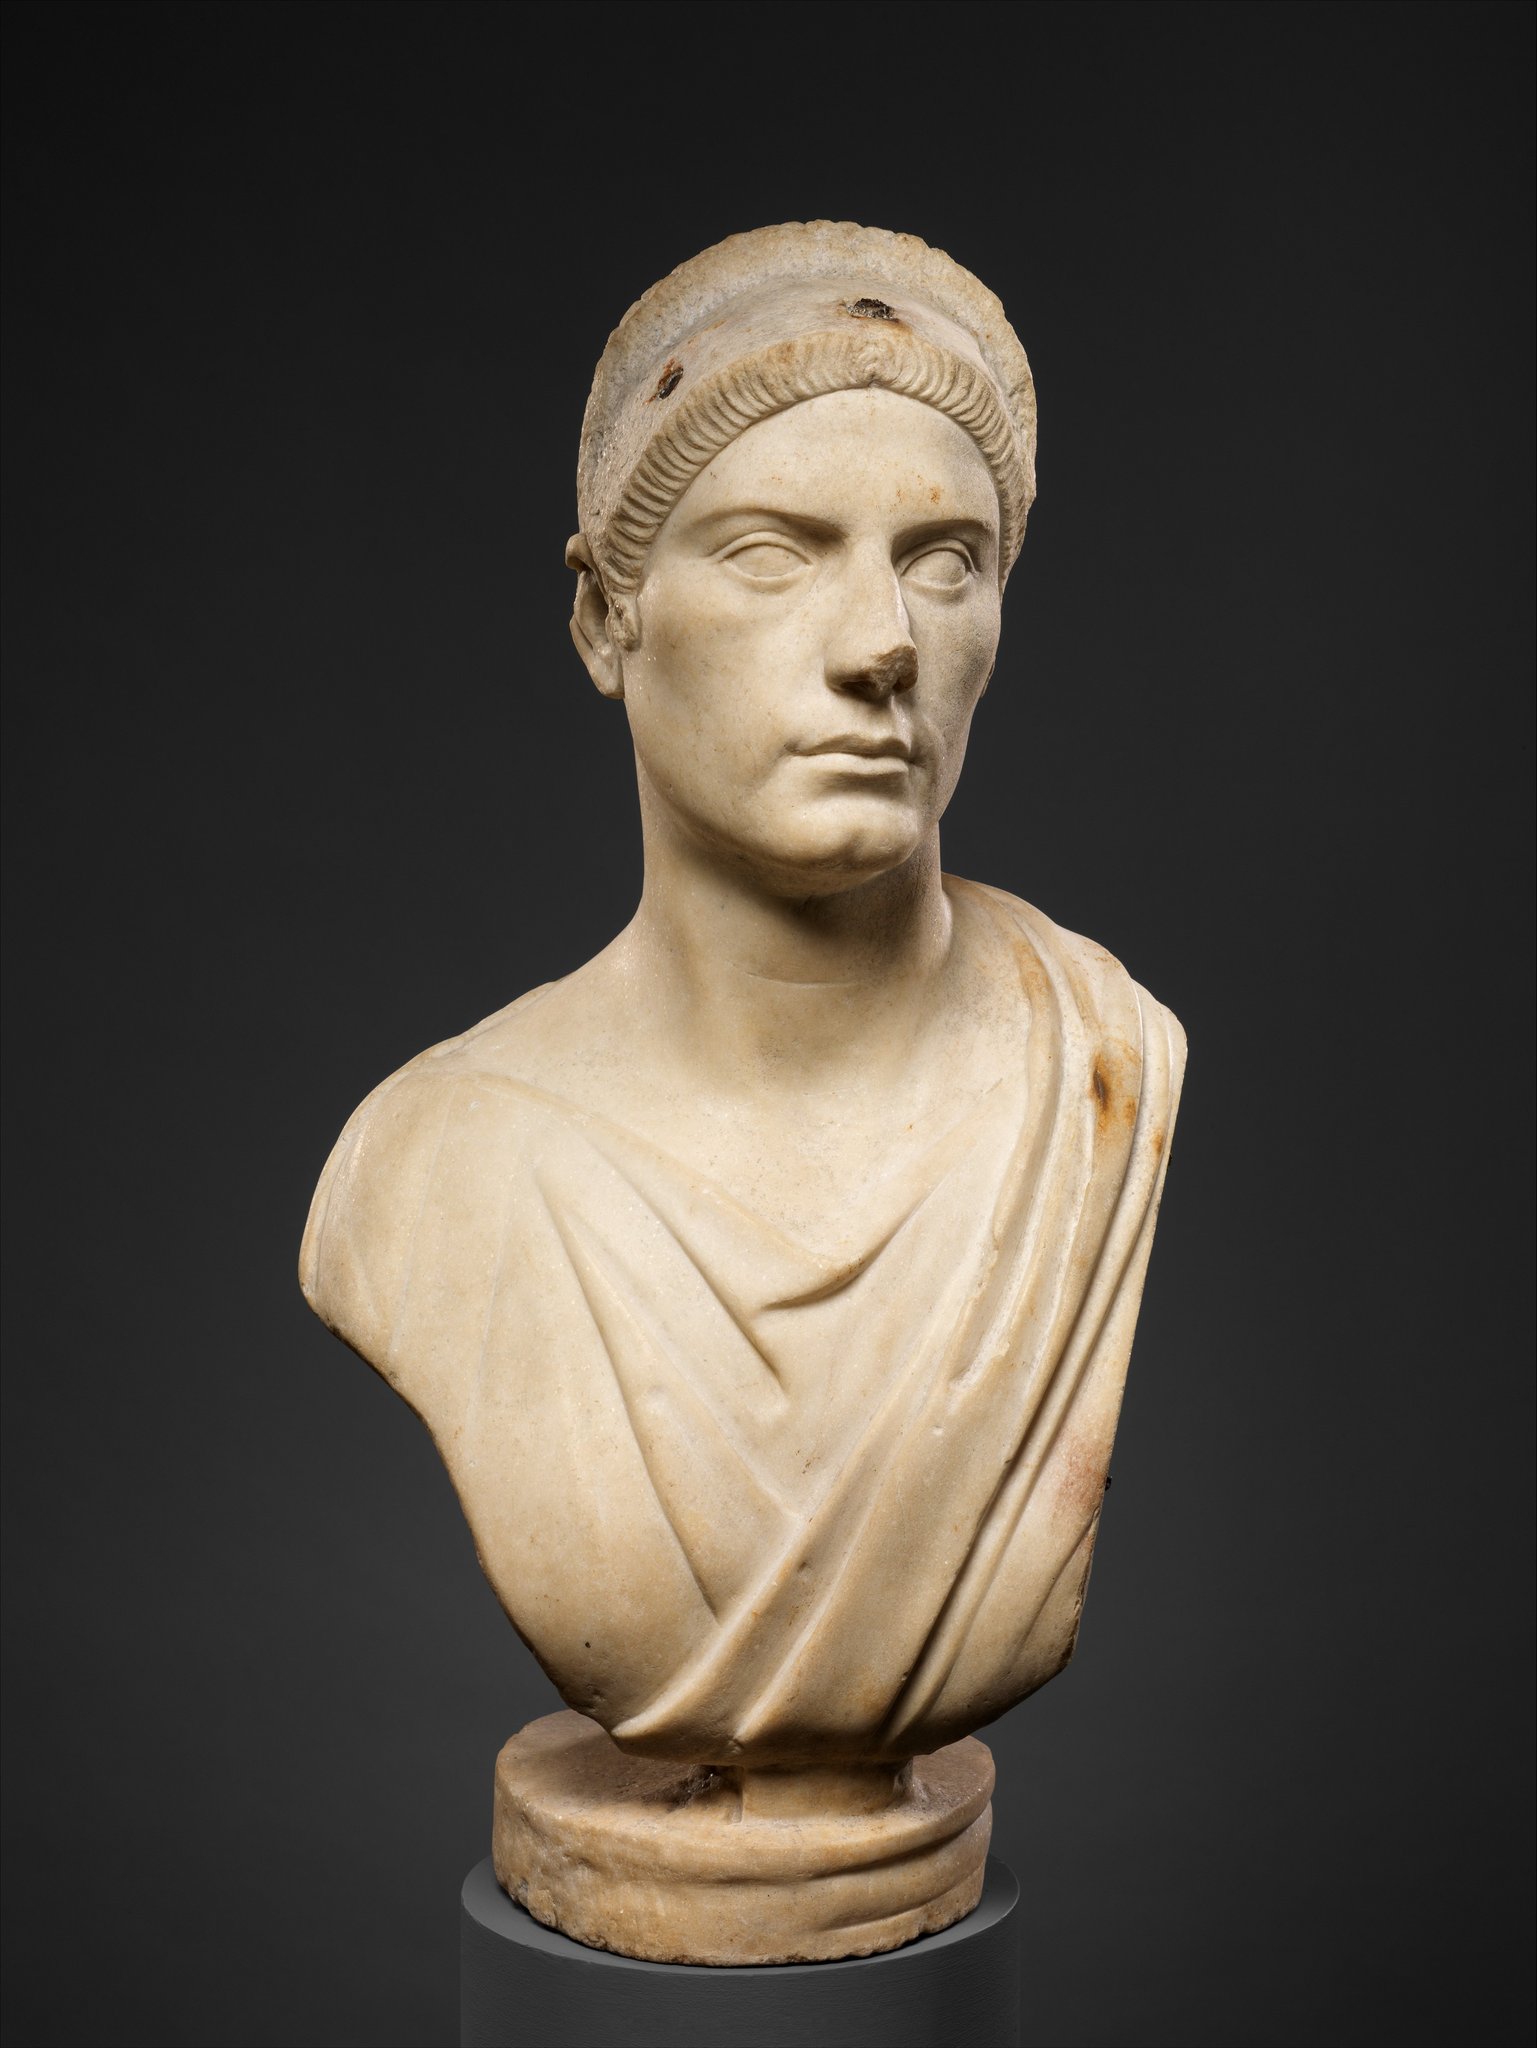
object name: portrait bust of a woman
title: Marble portrait bust of a woman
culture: roman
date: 100-120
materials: marble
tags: portraits,women